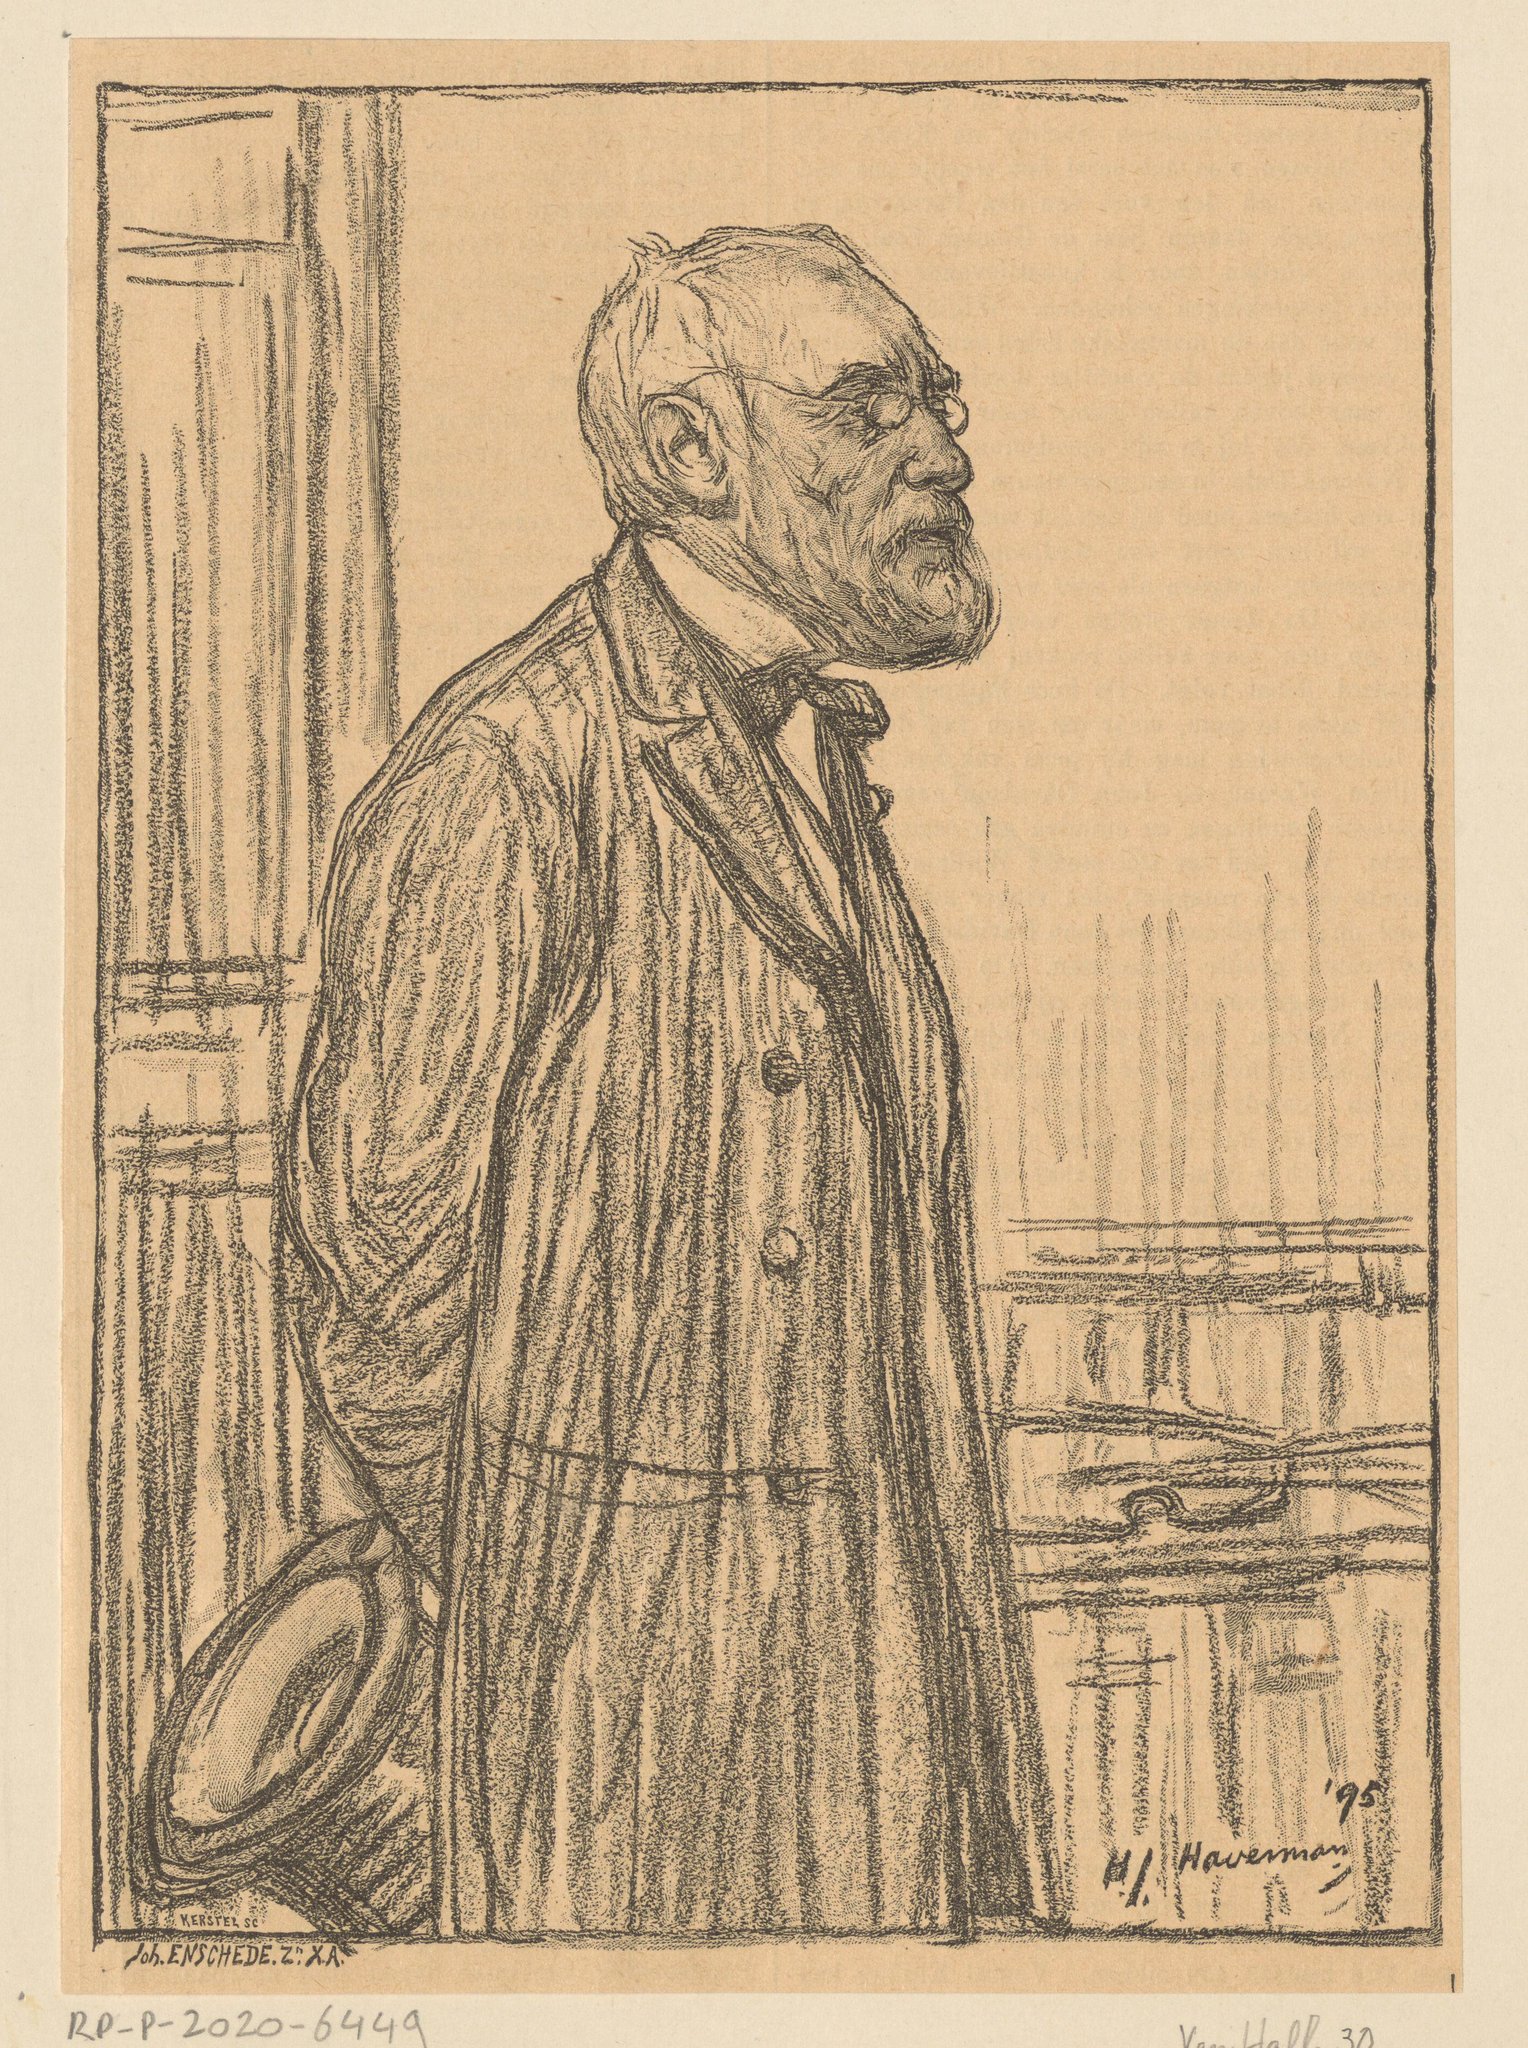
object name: print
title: Portret van Jozef Israëls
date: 1895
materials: paper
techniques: letterpress printing, engraving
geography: haarlem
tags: the hague, painter, draughtsman, jozef israëls, historical persons, portrait, self-portrait of painter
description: Prent met andere tekst op verso gebruikt in: Woord & beeld. Geïllustreerd maandblad, januari 1896.